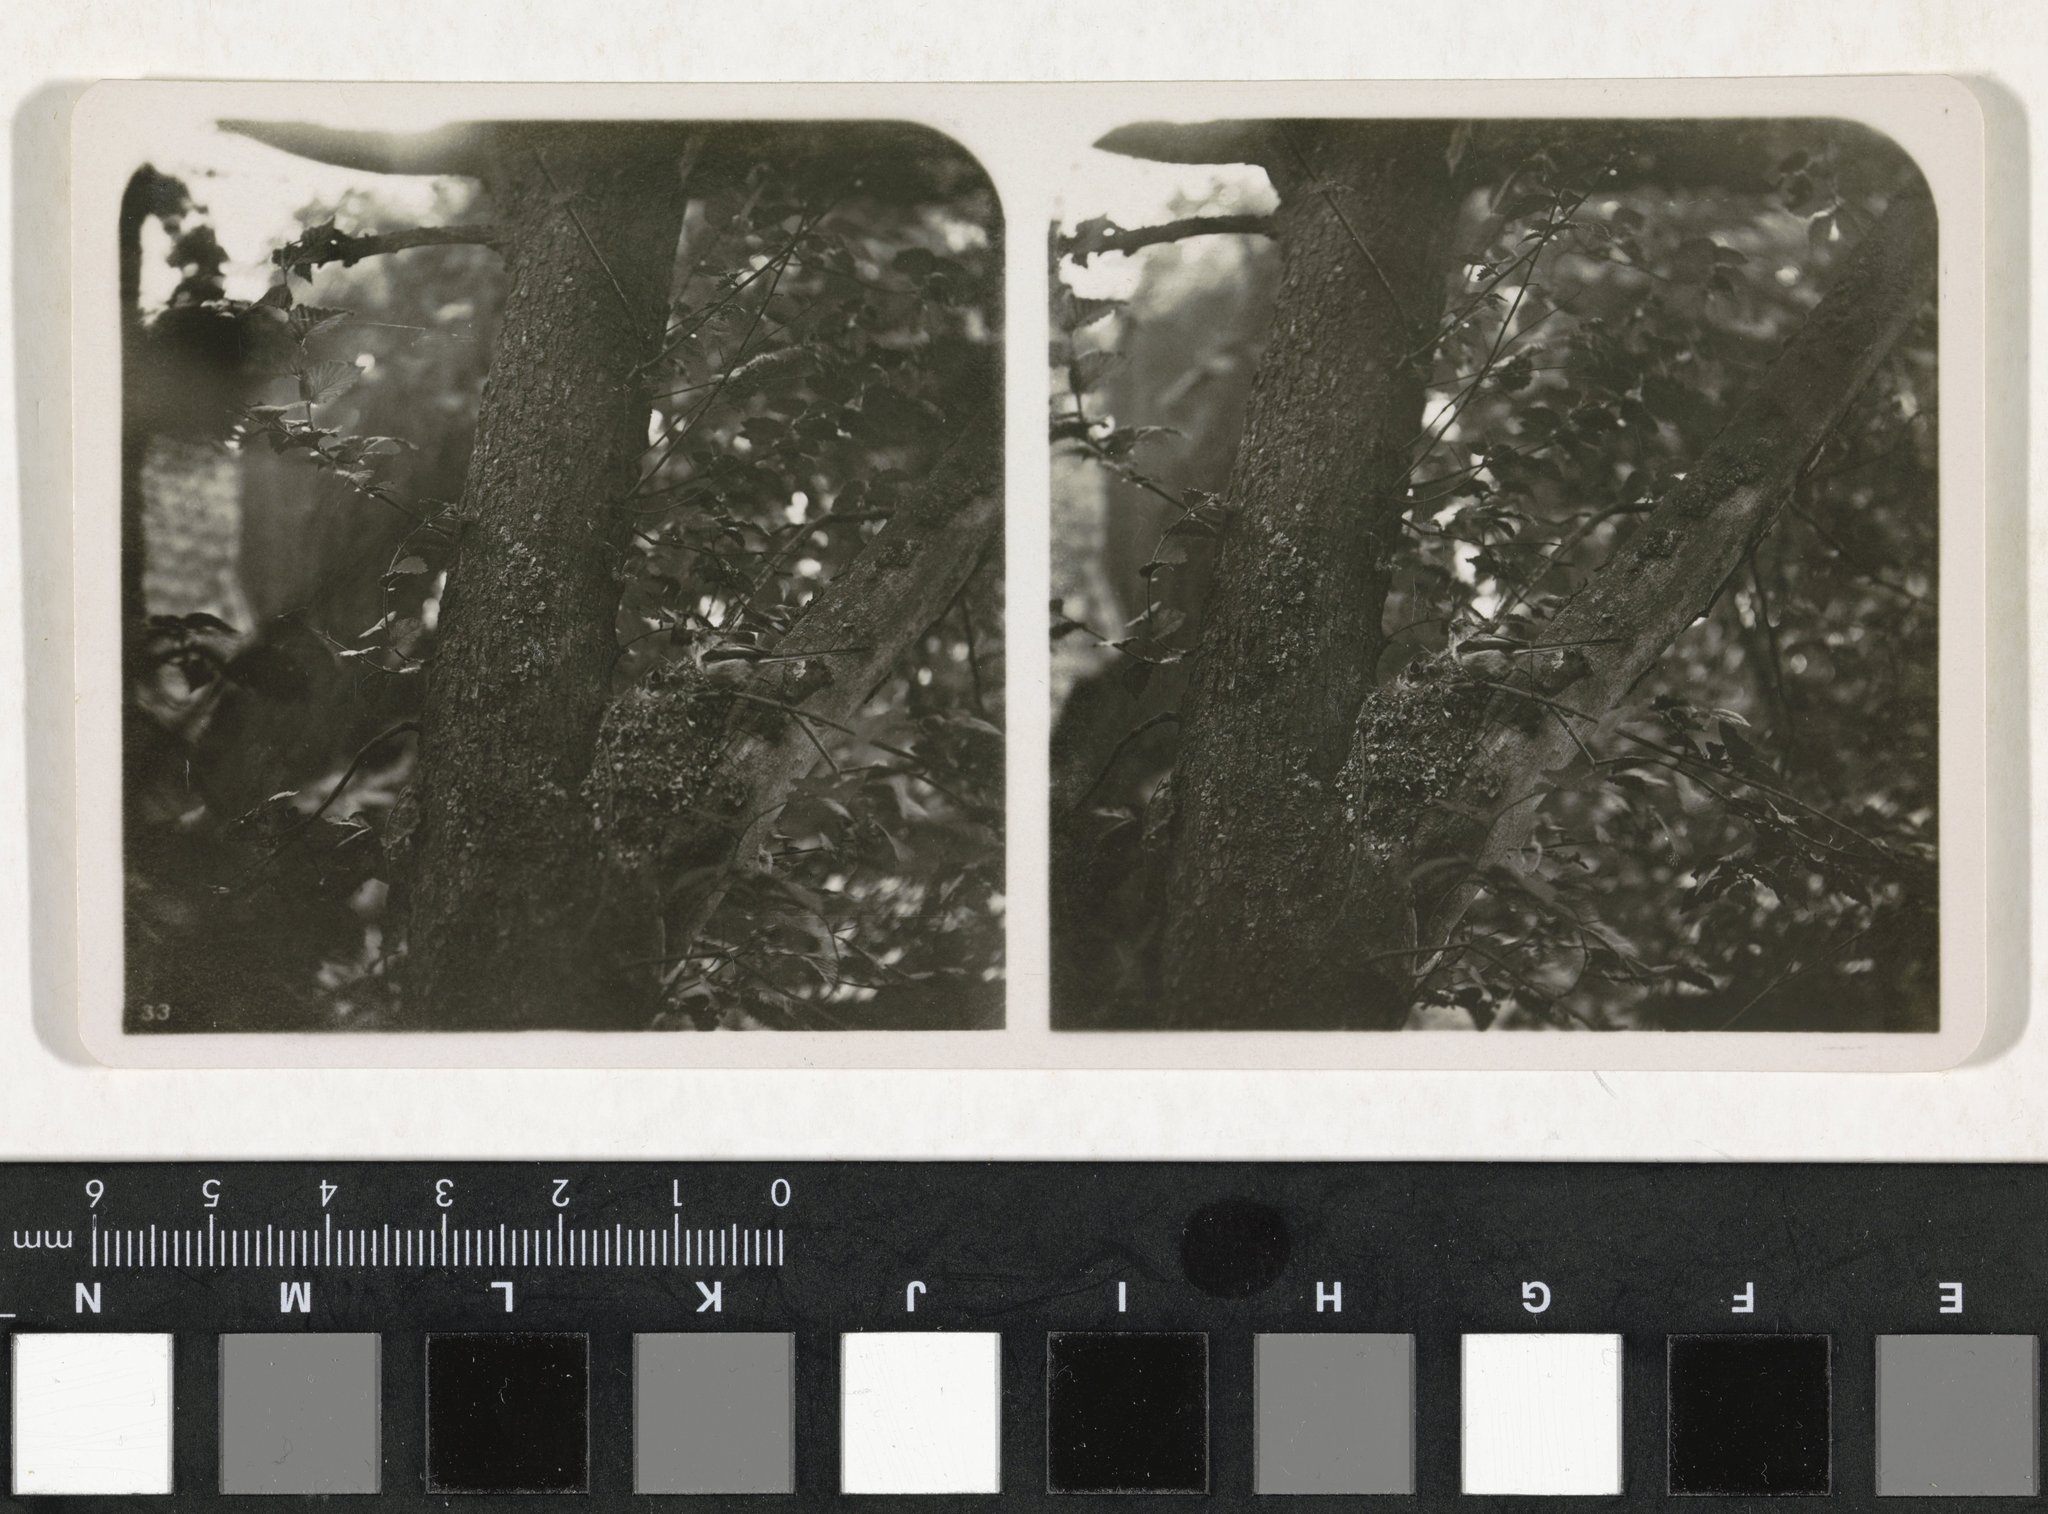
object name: stereograph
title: Staartmees bij nest met jongen in boom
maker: adolphe burdet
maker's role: fotograaf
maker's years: 1860-1940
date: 1870-1940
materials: photographic support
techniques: gelatin silver print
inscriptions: label: ‘33 / Orites caudatus L. / Mésange à longue queue / Staartmees...’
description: Linksonder op de foto links staat het nummer 33. Uit serie van 25 stereofoto's.